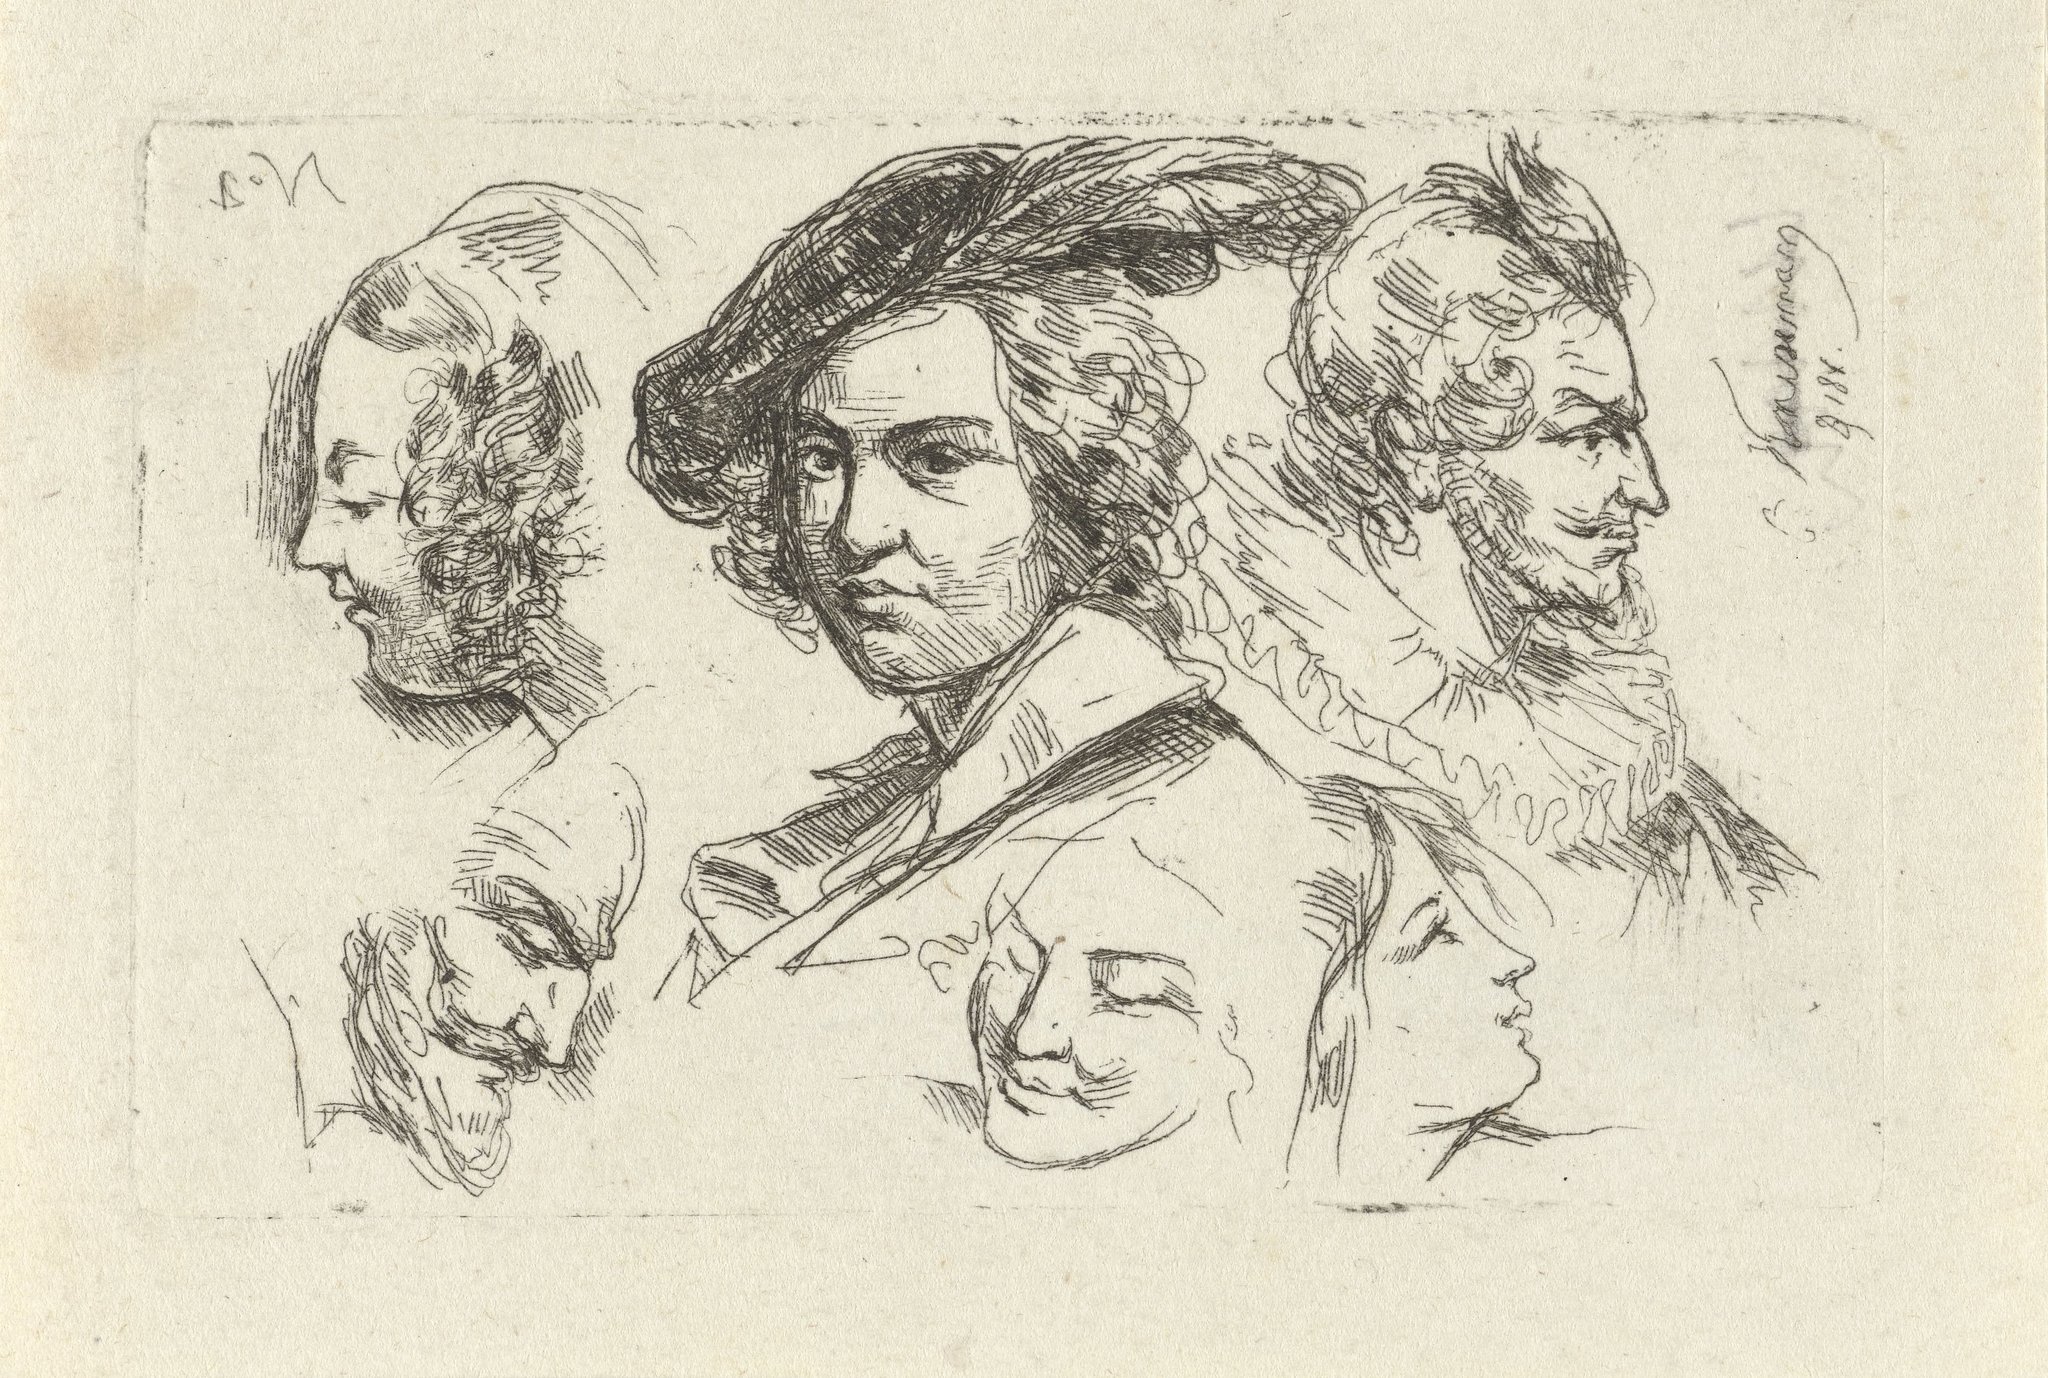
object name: print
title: Studieblad met zes koppen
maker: cornelis kruseman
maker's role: draughtsman, painter, print maker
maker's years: 1797-1857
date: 1818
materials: paper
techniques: etching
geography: netherlands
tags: drawing, sketch, head (human)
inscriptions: collector's mark: Lugt 2228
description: Studieblad met zes verschillende koppen van mannen en vrouwen.